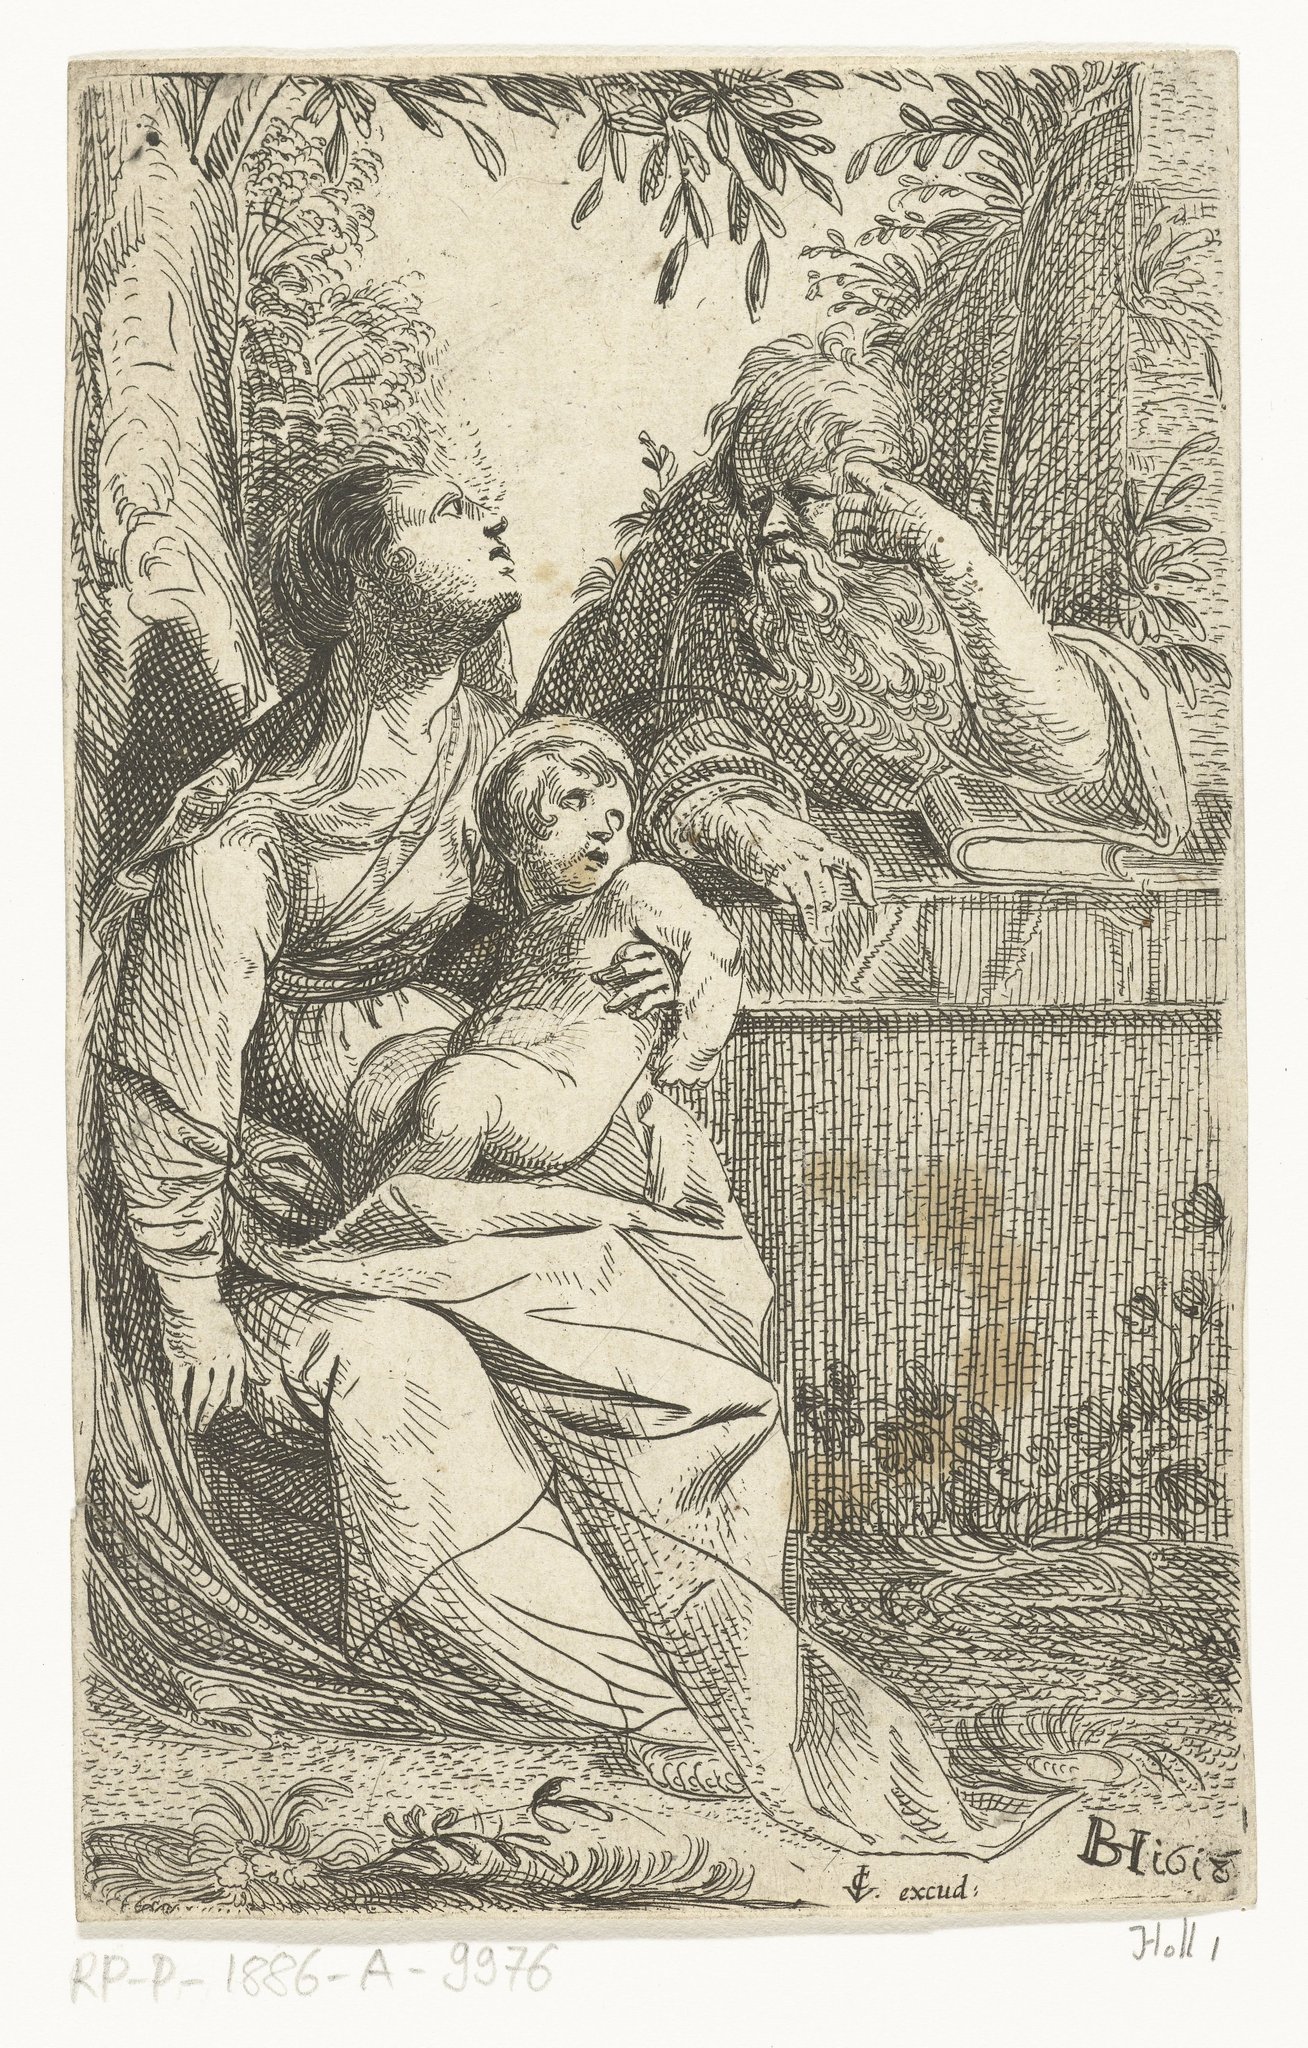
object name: print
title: Heilige familie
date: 1618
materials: paper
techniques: engraving, etching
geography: amsterdam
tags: holy family, and derived representations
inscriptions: collector's mark: Lugt 2228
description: De heilige familie zit in de tuin. Jozef zit aan een tafel en leunt op een boek. Maria met Christus op haar schoot zit naast hem en kijkt naar hem op.